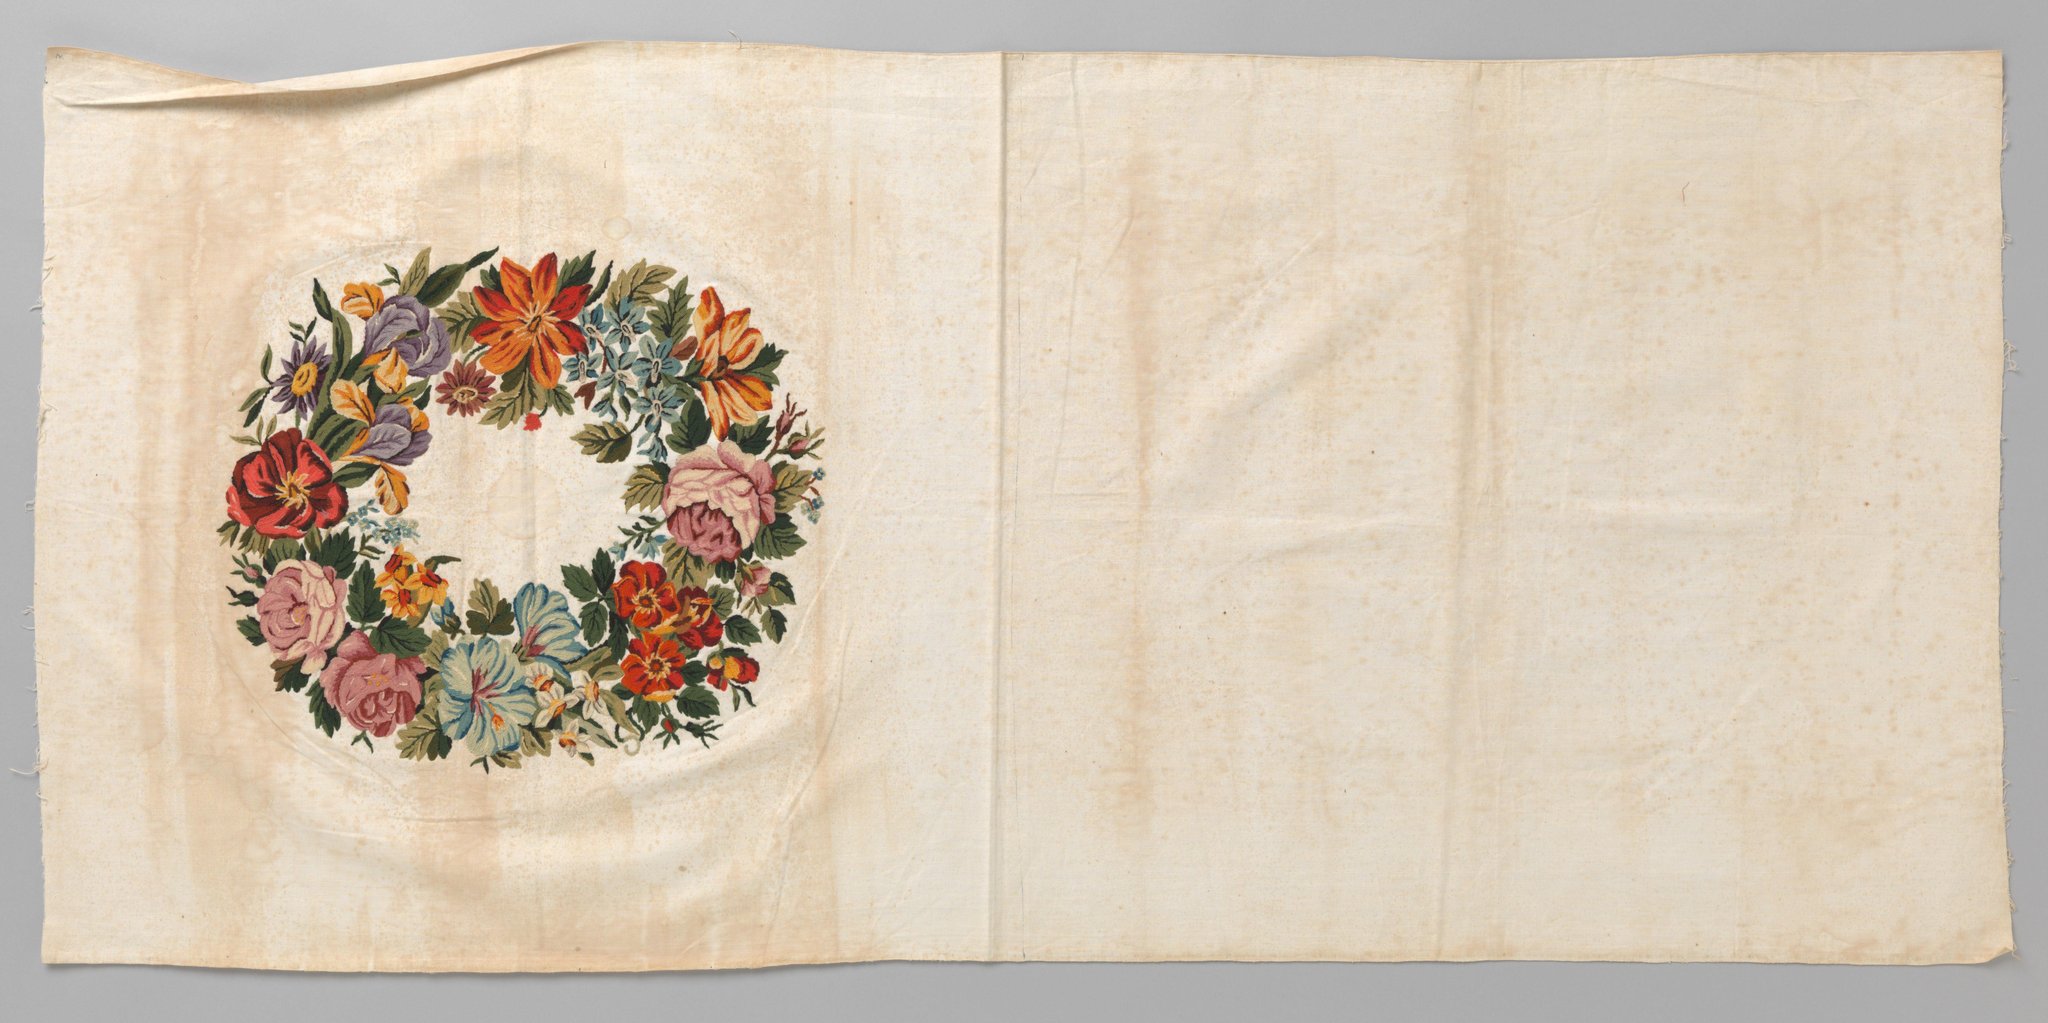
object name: bekledingsstof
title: Metrage bekledingsstof met borduurwerk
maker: Anonymous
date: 1850-1949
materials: cotton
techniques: weave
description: Metrage bekledingsstof, geborduurd met kleurige bloemenkransen in kettingsteek.